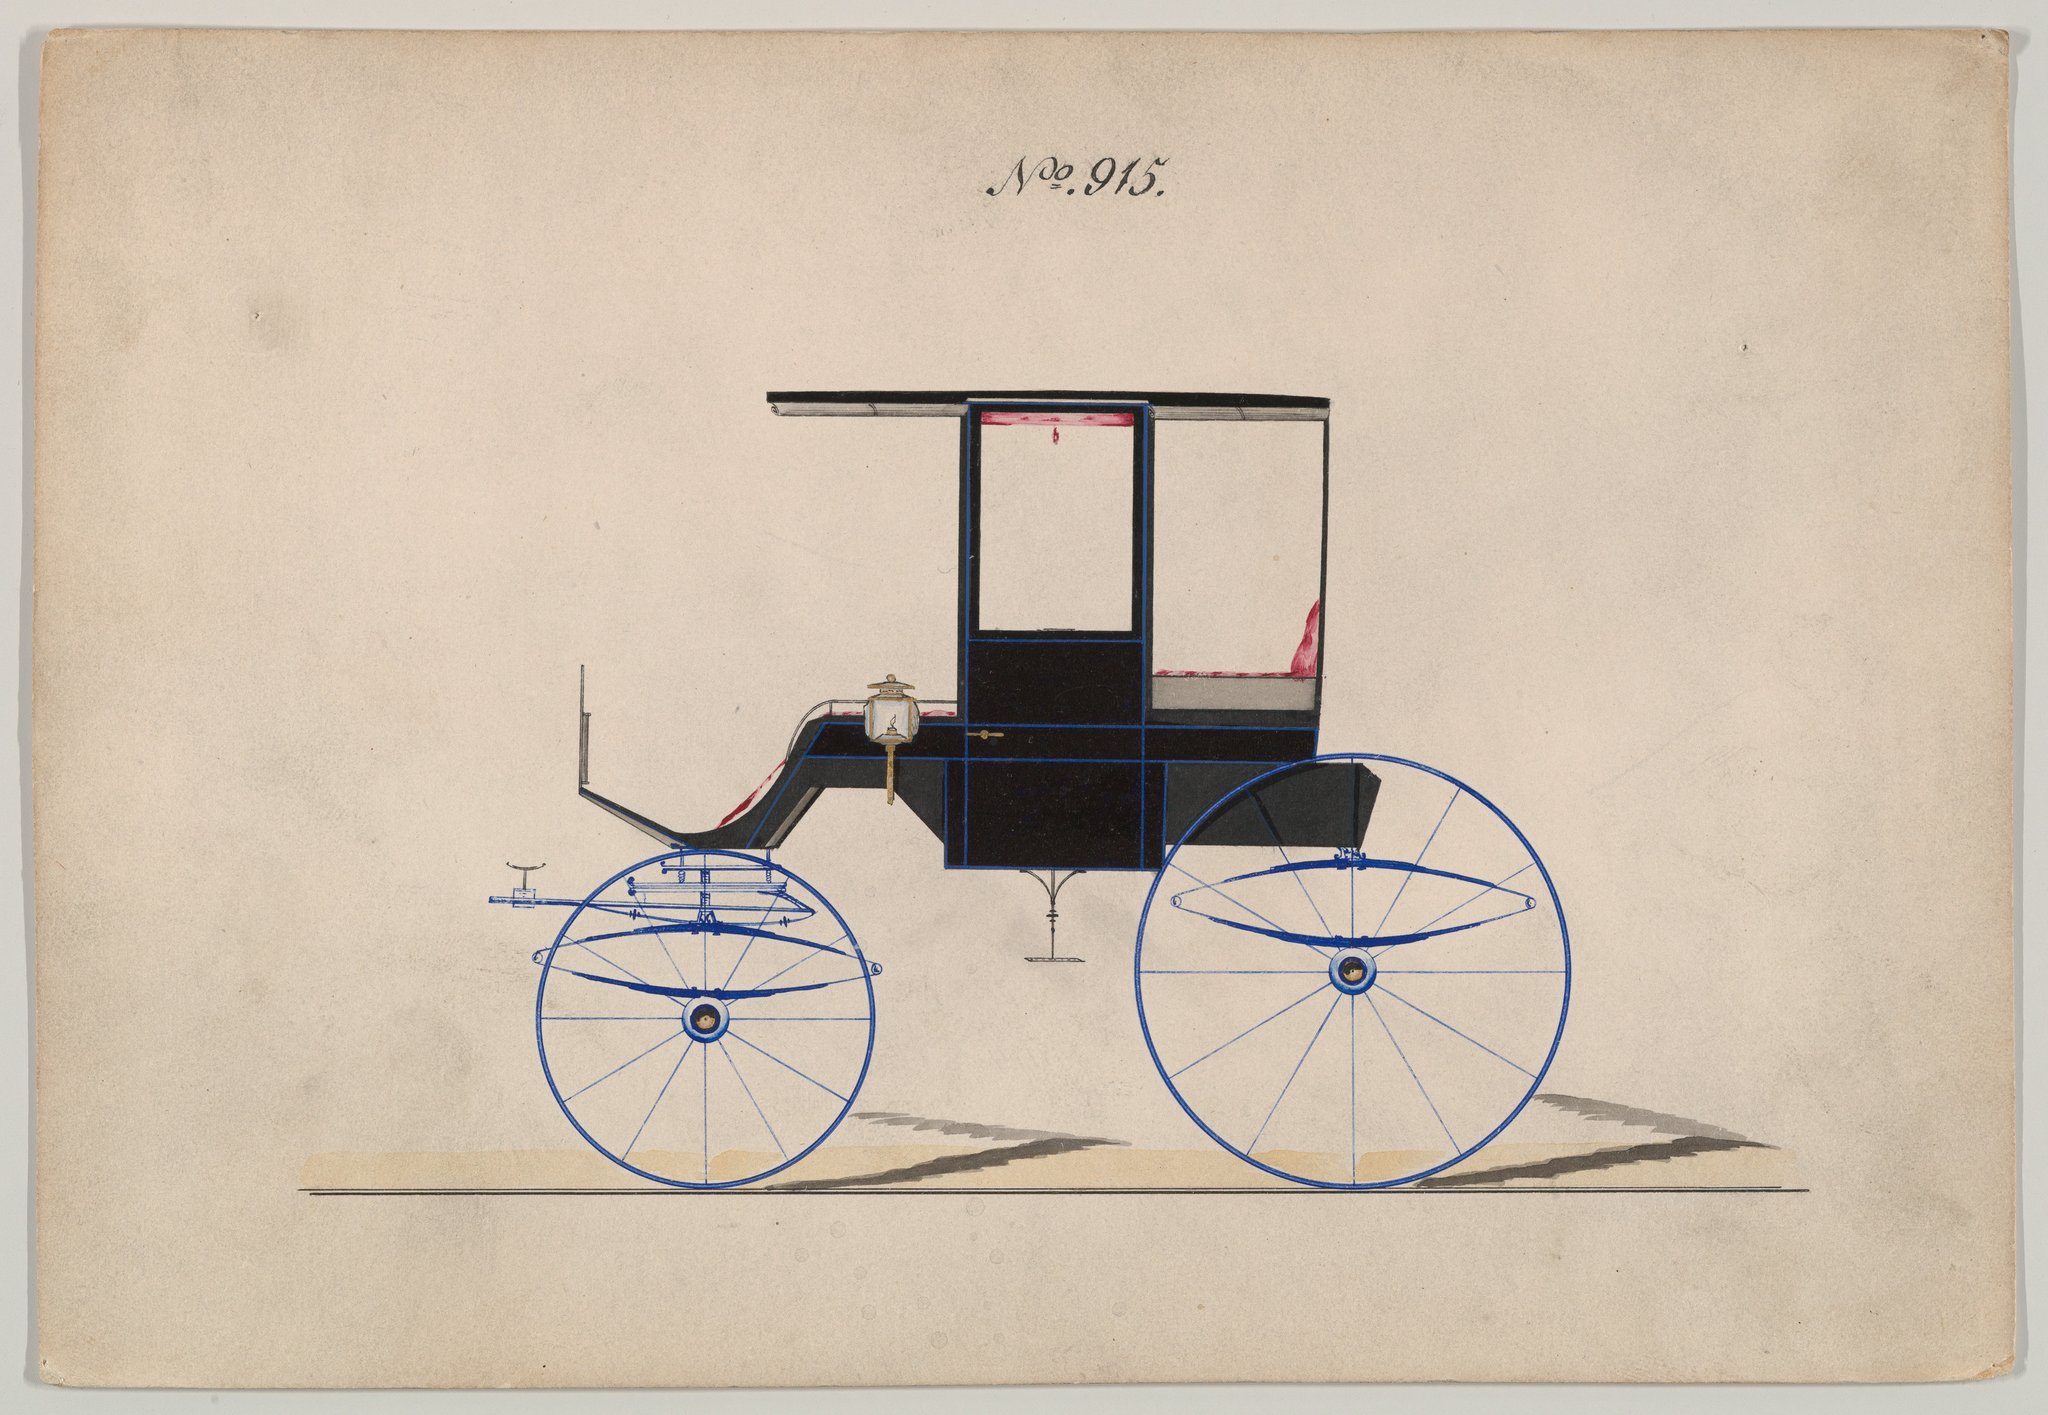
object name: drawing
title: Rockaway #915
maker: brewster & co.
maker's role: manufacturer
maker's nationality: american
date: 1870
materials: gouache, gum arabic, ink, watercolor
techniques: pen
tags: carriages